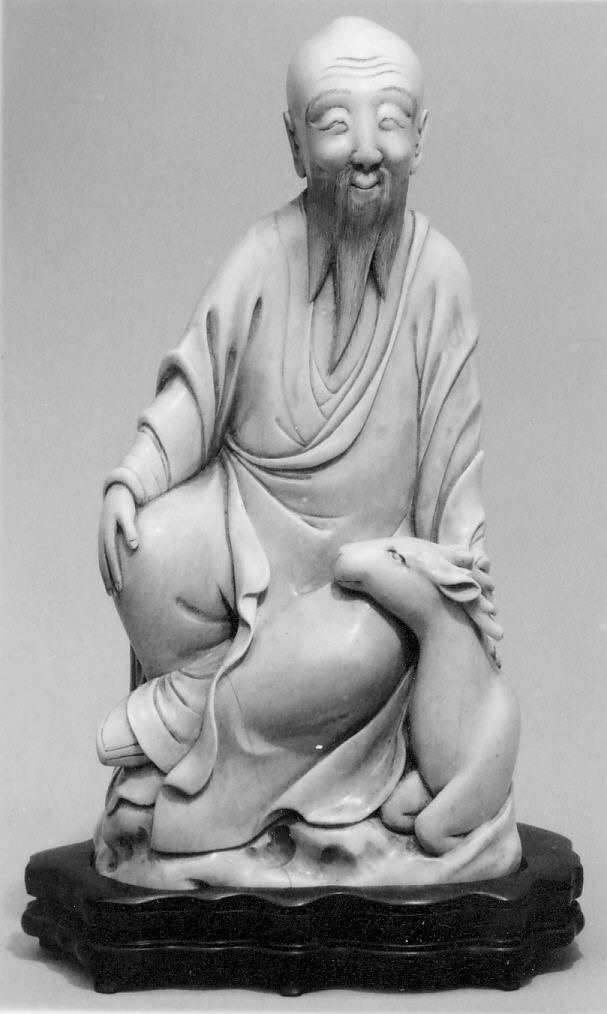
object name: statuette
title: Jurōjin, God of Longevity and Wisdom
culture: japanese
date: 1867-1900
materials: ivory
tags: animals,daoism